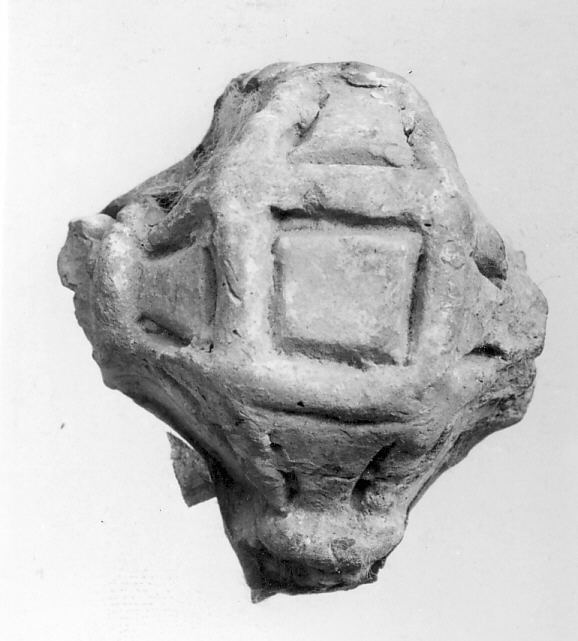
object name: ornament fragment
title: Fragment of an Ornament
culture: central asian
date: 1101-1133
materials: mud